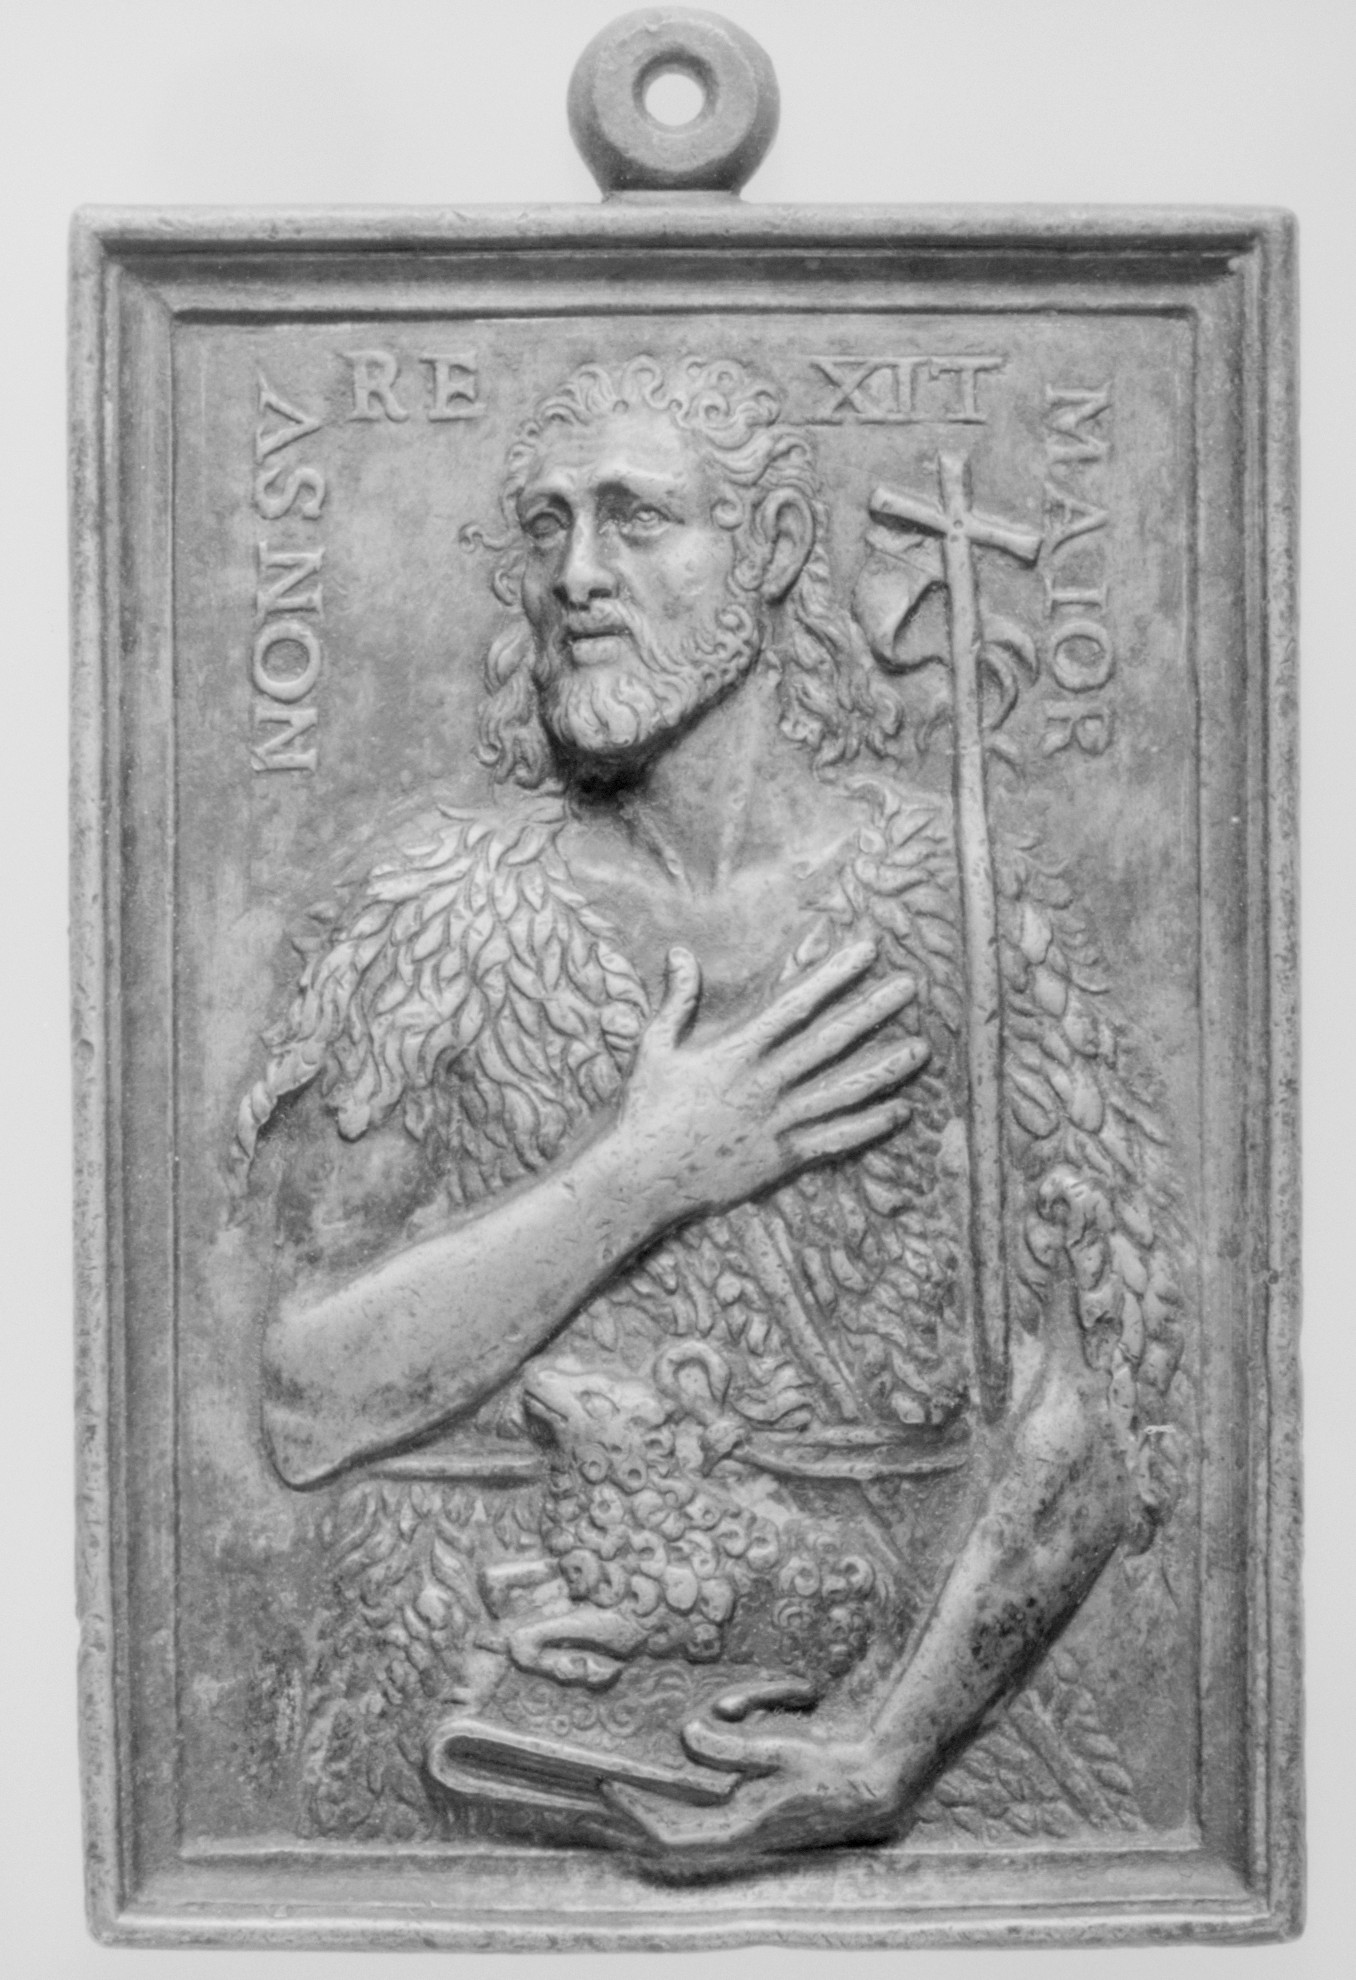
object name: plaquette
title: St. John the Baptist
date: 1501-1600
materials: bronze, gilt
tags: saint john the baptist,cross